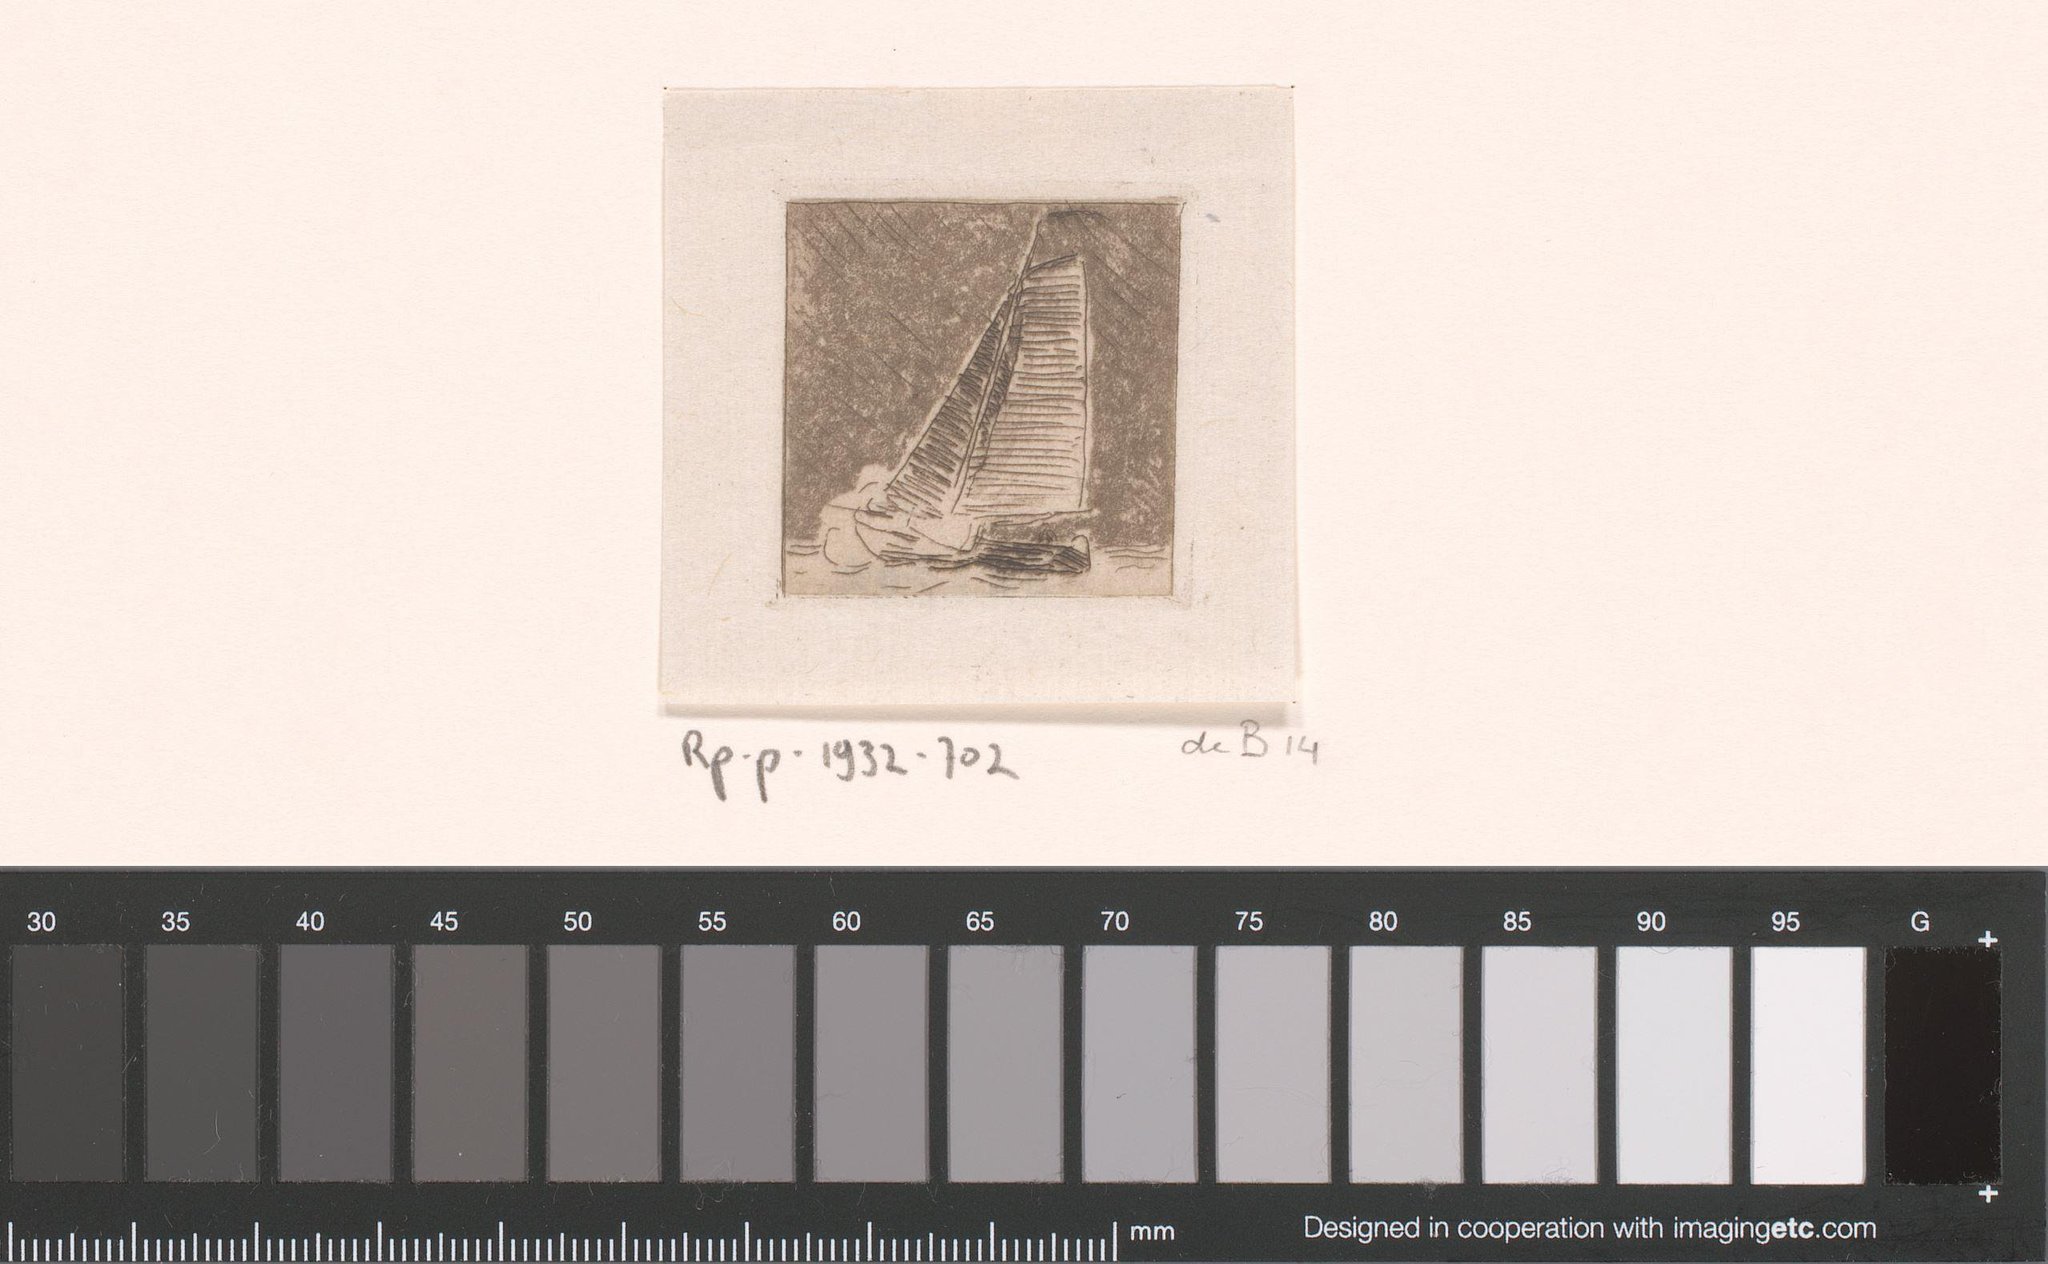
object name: print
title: Botter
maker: willem bastiaan tholen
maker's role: draughtsman, painter, print maker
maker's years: 1860-1931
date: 1870-1931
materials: paper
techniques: etching, intaglio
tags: sailing-ship, sailing-boat